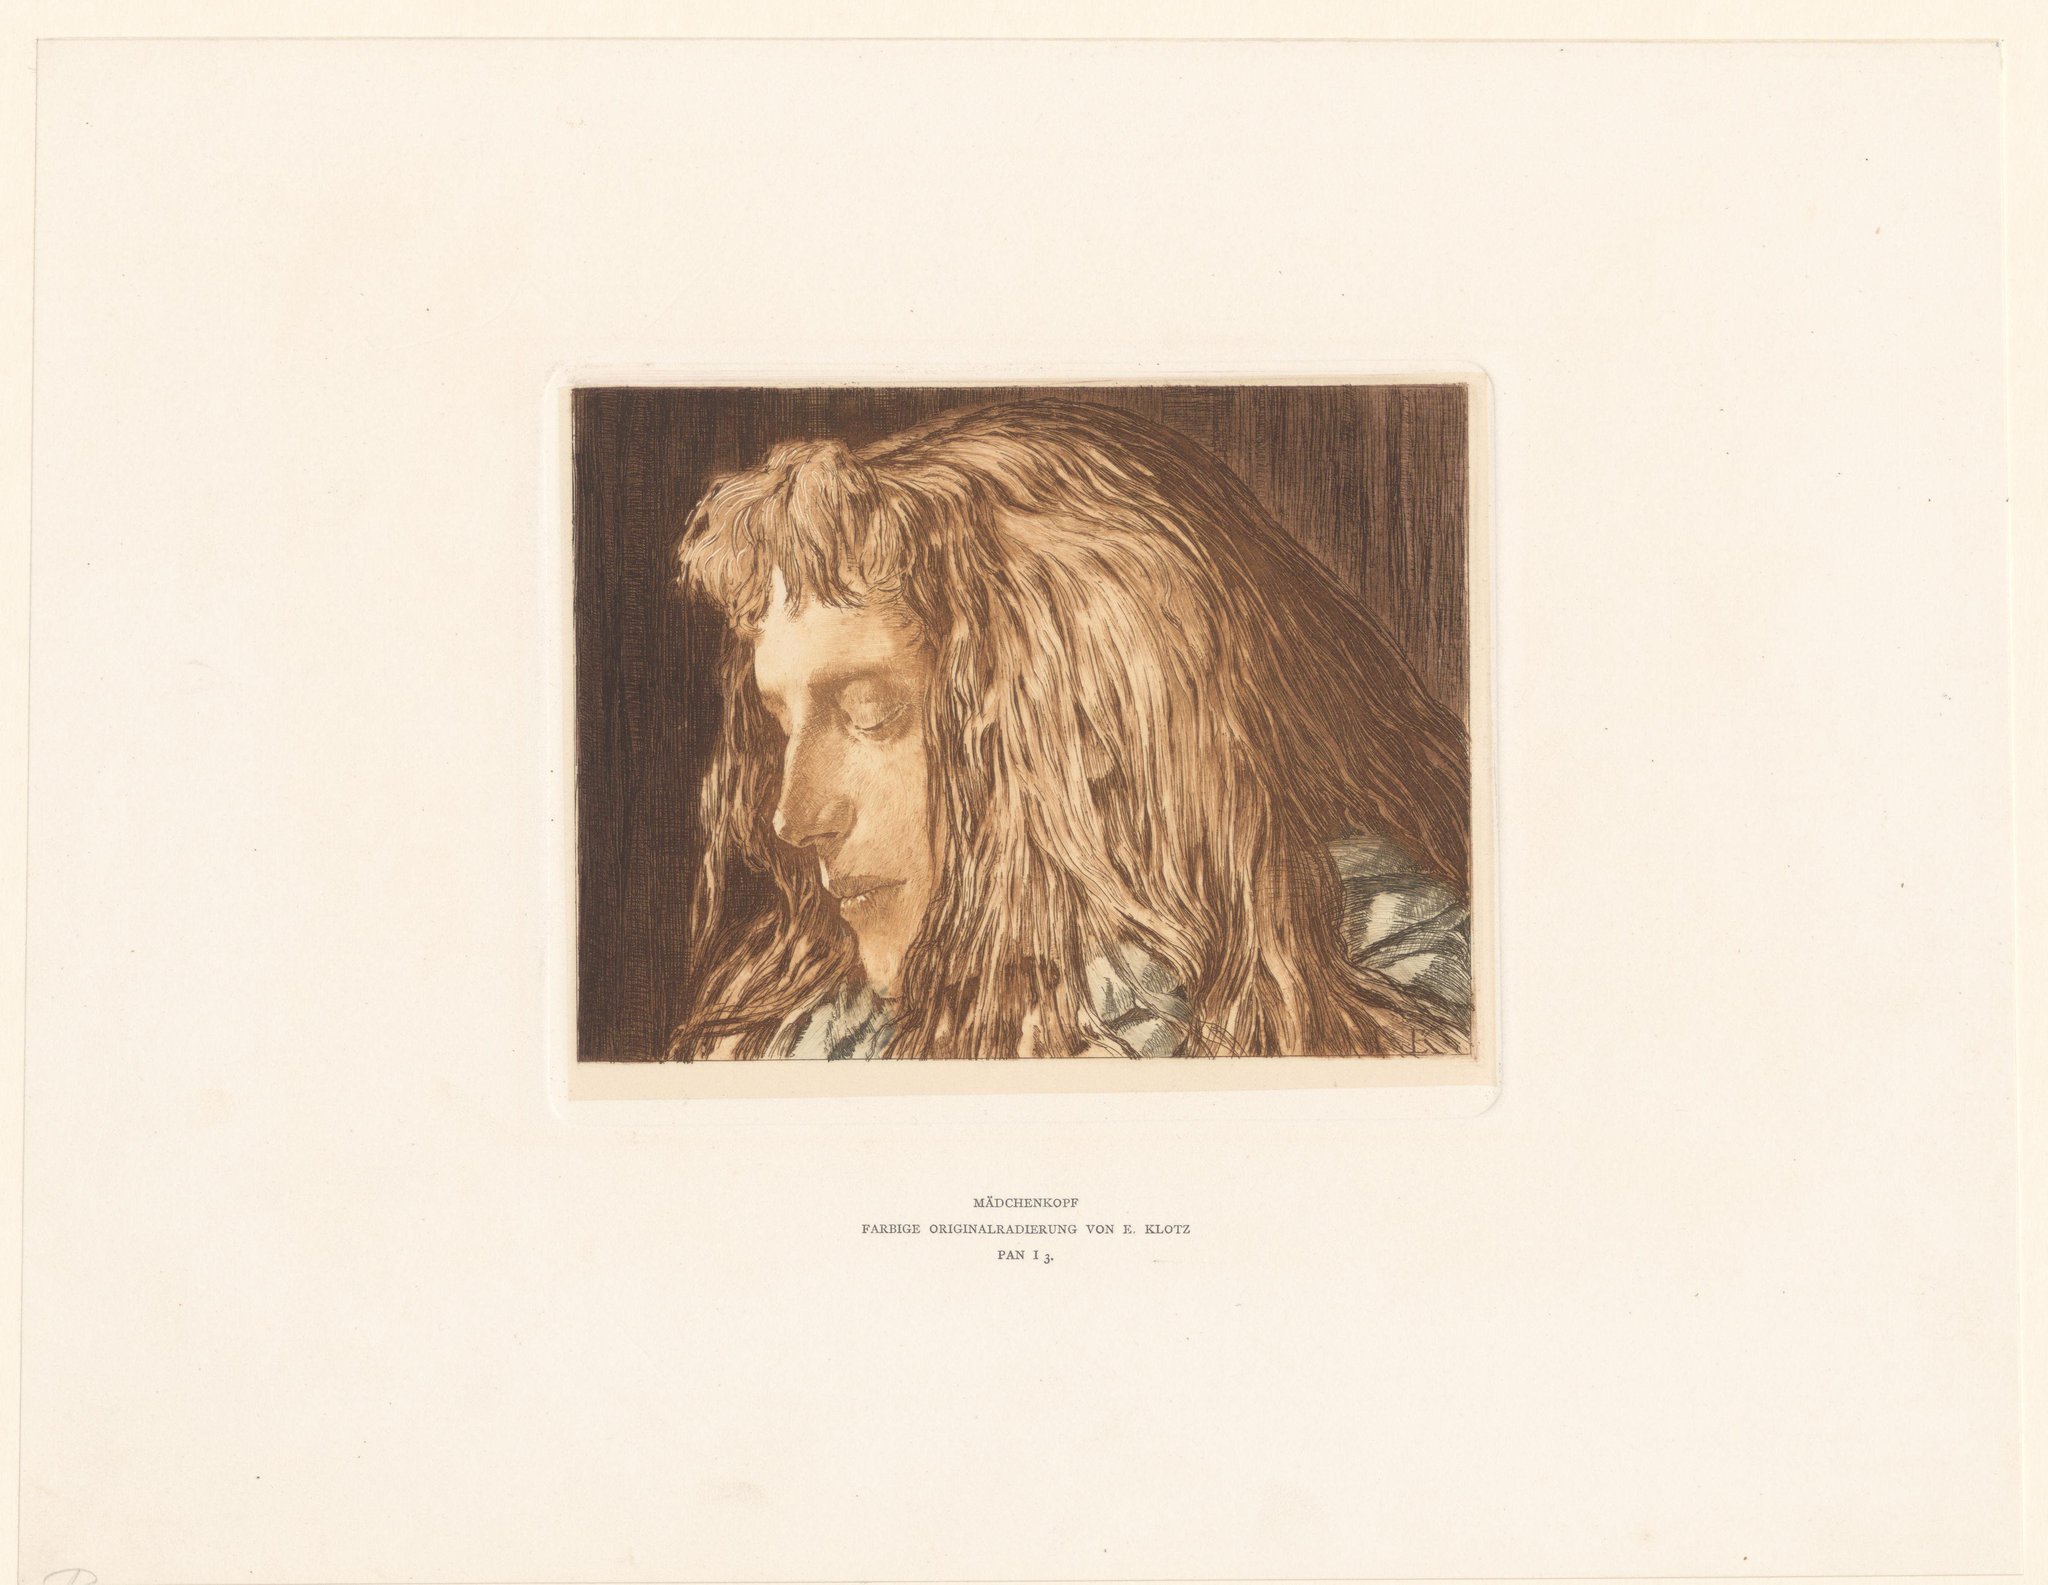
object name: print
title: Portret van een onbekende vrouw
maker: ernst klotz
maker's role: print maker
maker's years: 1863-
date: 1895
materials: paper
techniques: etching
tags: anonymous historical person portrayed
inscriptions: collector's mark: Lugt 2228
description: Deze prent is gedrukt in het tijdschrift Pan (volume 1, nr. 3) in 1895.